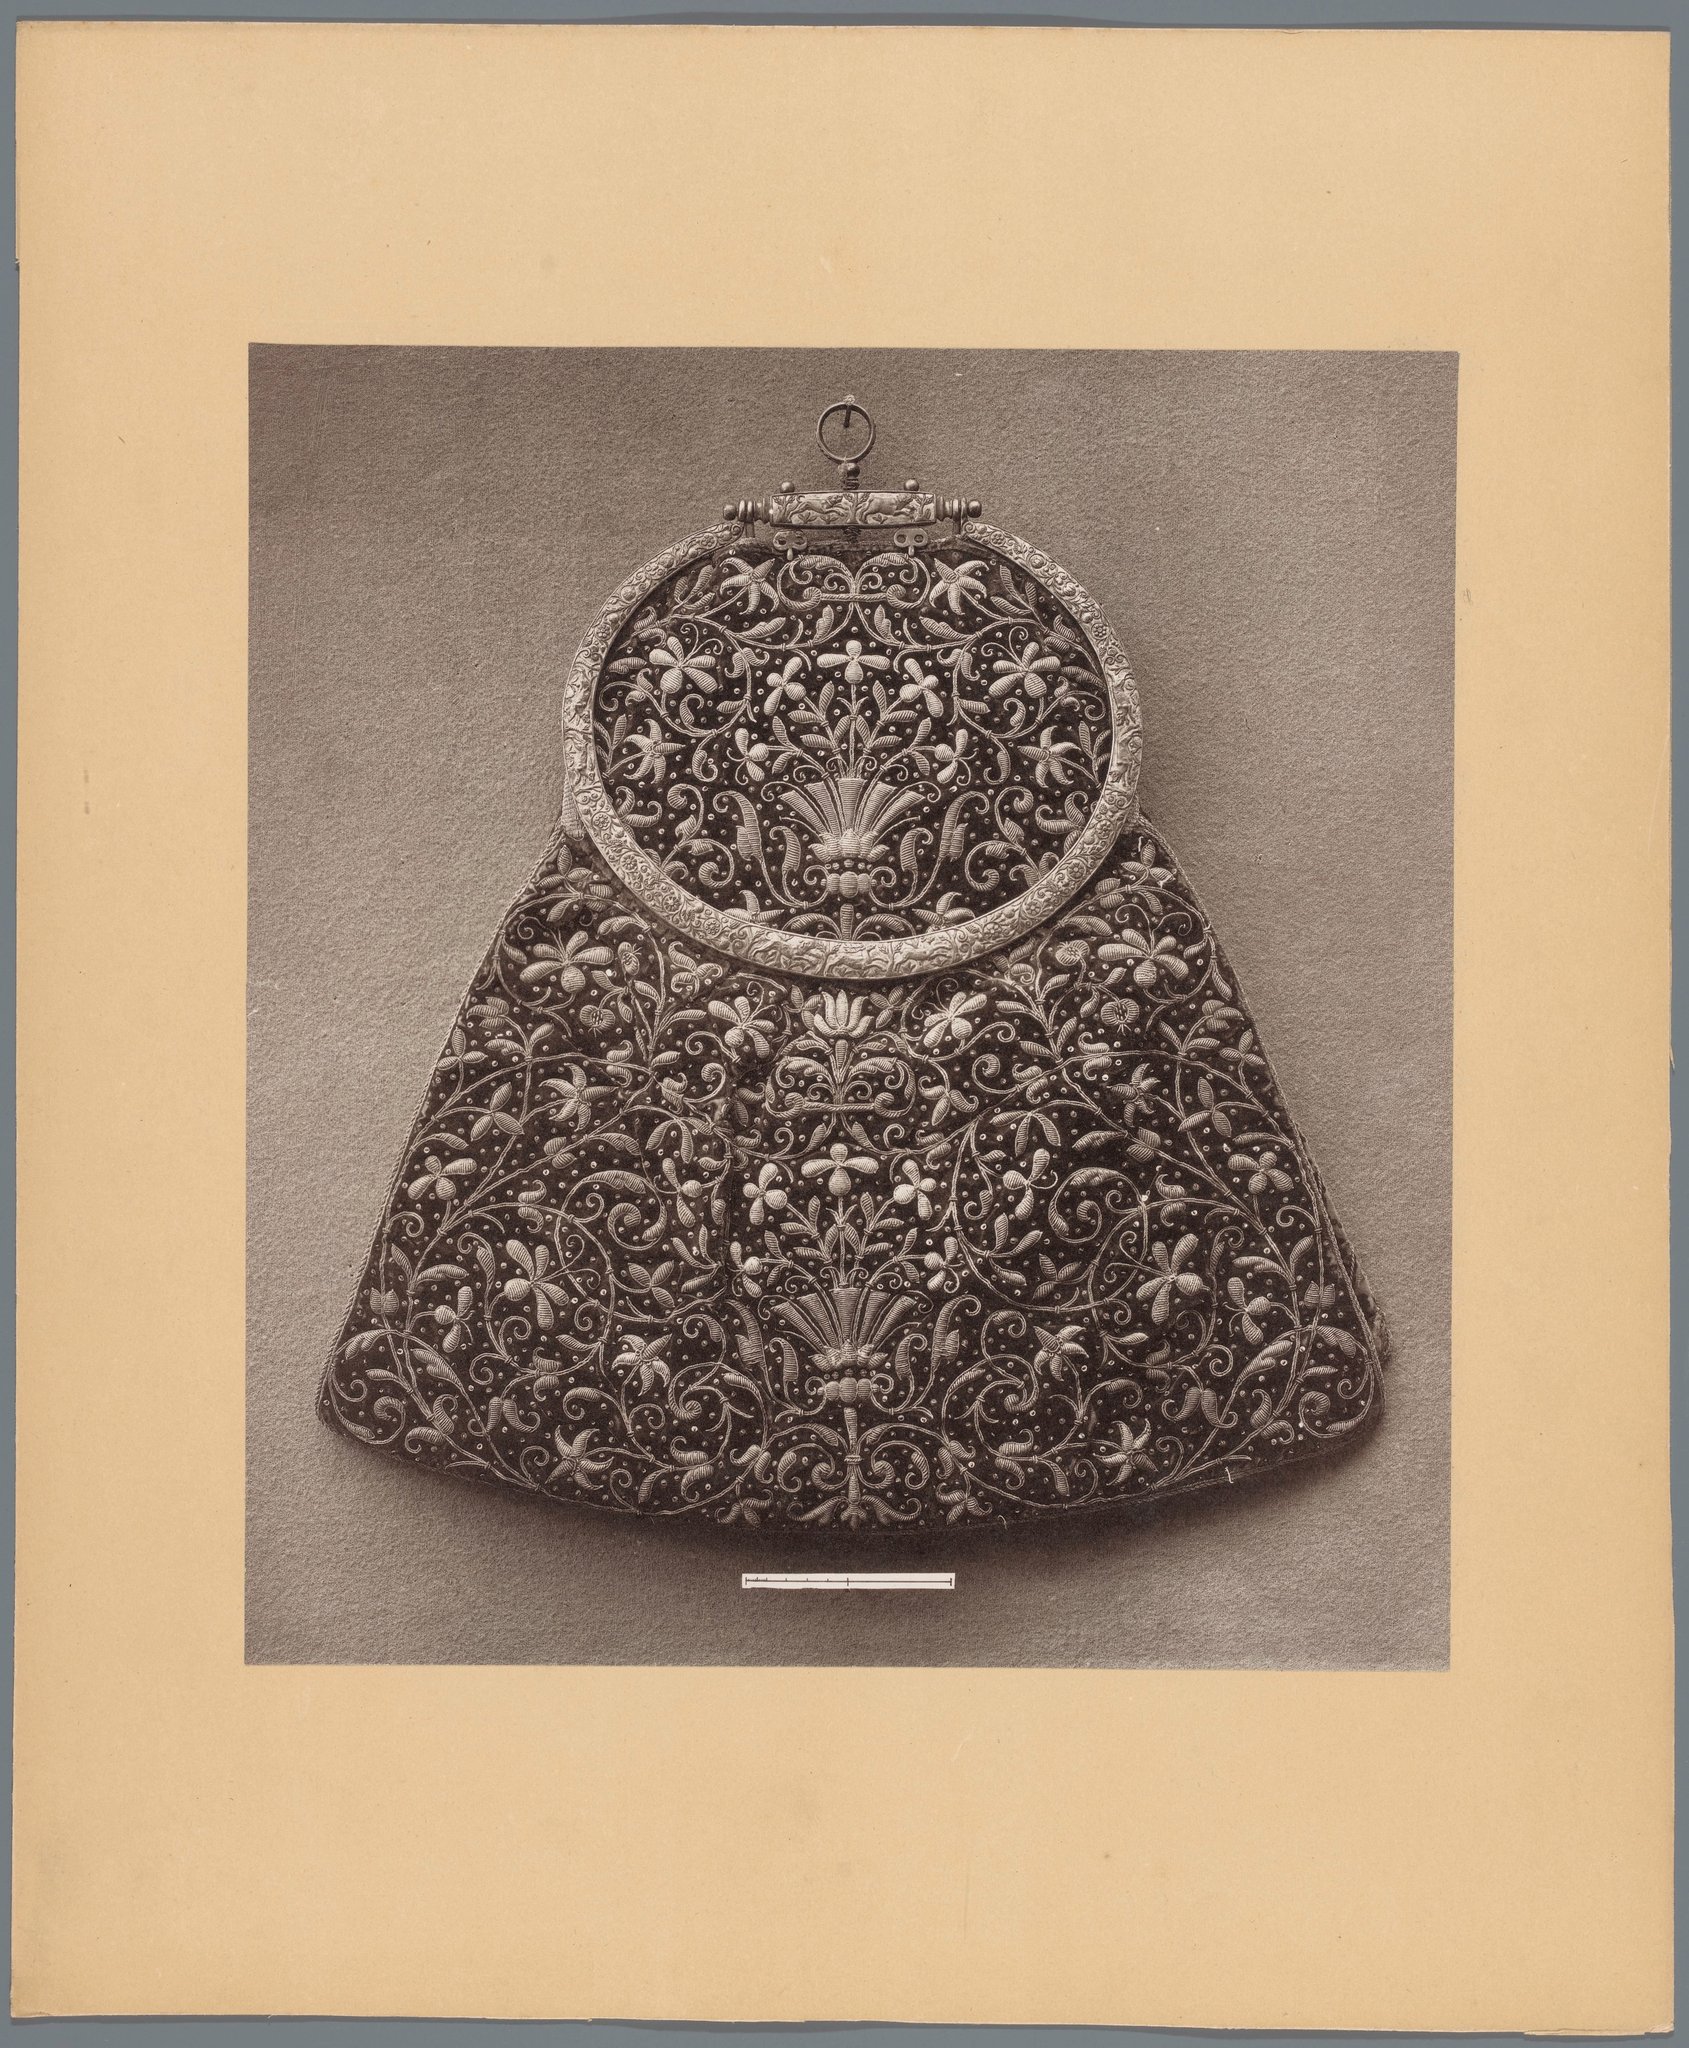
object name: photograph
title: Tas van textiel gedecoreerd met bloemmotieven en een metalen sluiting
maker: Anonymous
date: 1875-1900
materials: cardboard, paper, ink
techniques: photograph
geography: europe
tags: bag, flowers ~ ornament, europe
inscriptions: collector's mark: Lugt 3937